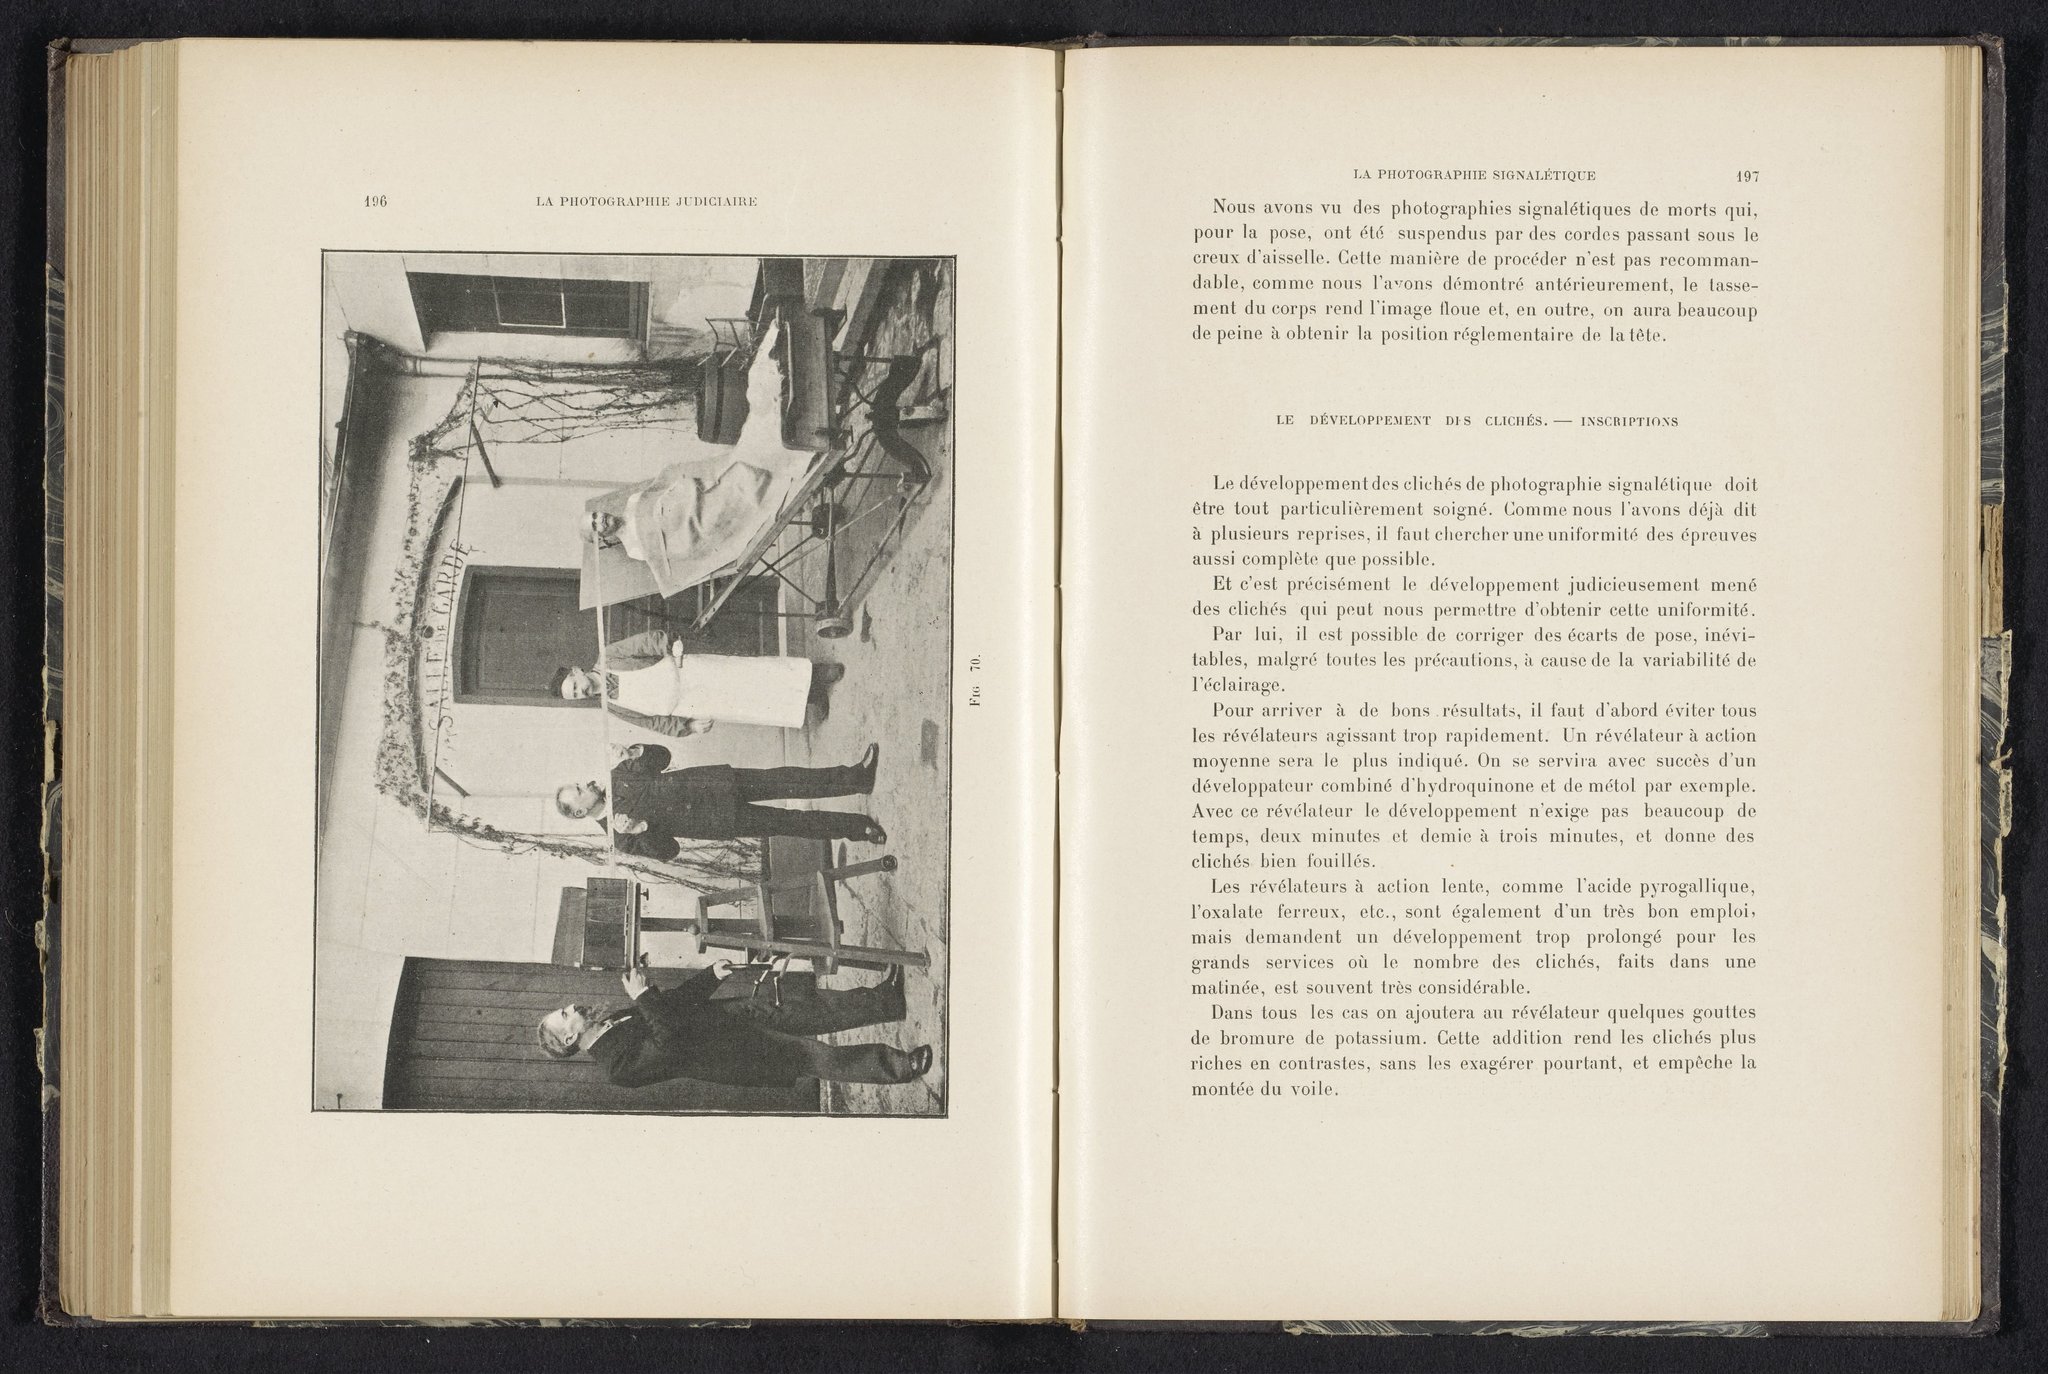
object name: page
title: Opstelling in een fotostudio voor het fotograferen van een lijk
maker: Anonymous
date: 1893-1903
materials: paper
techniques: autotype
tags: studio ~ photographer, the corpse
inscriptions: number: ‘Fig. 70.’